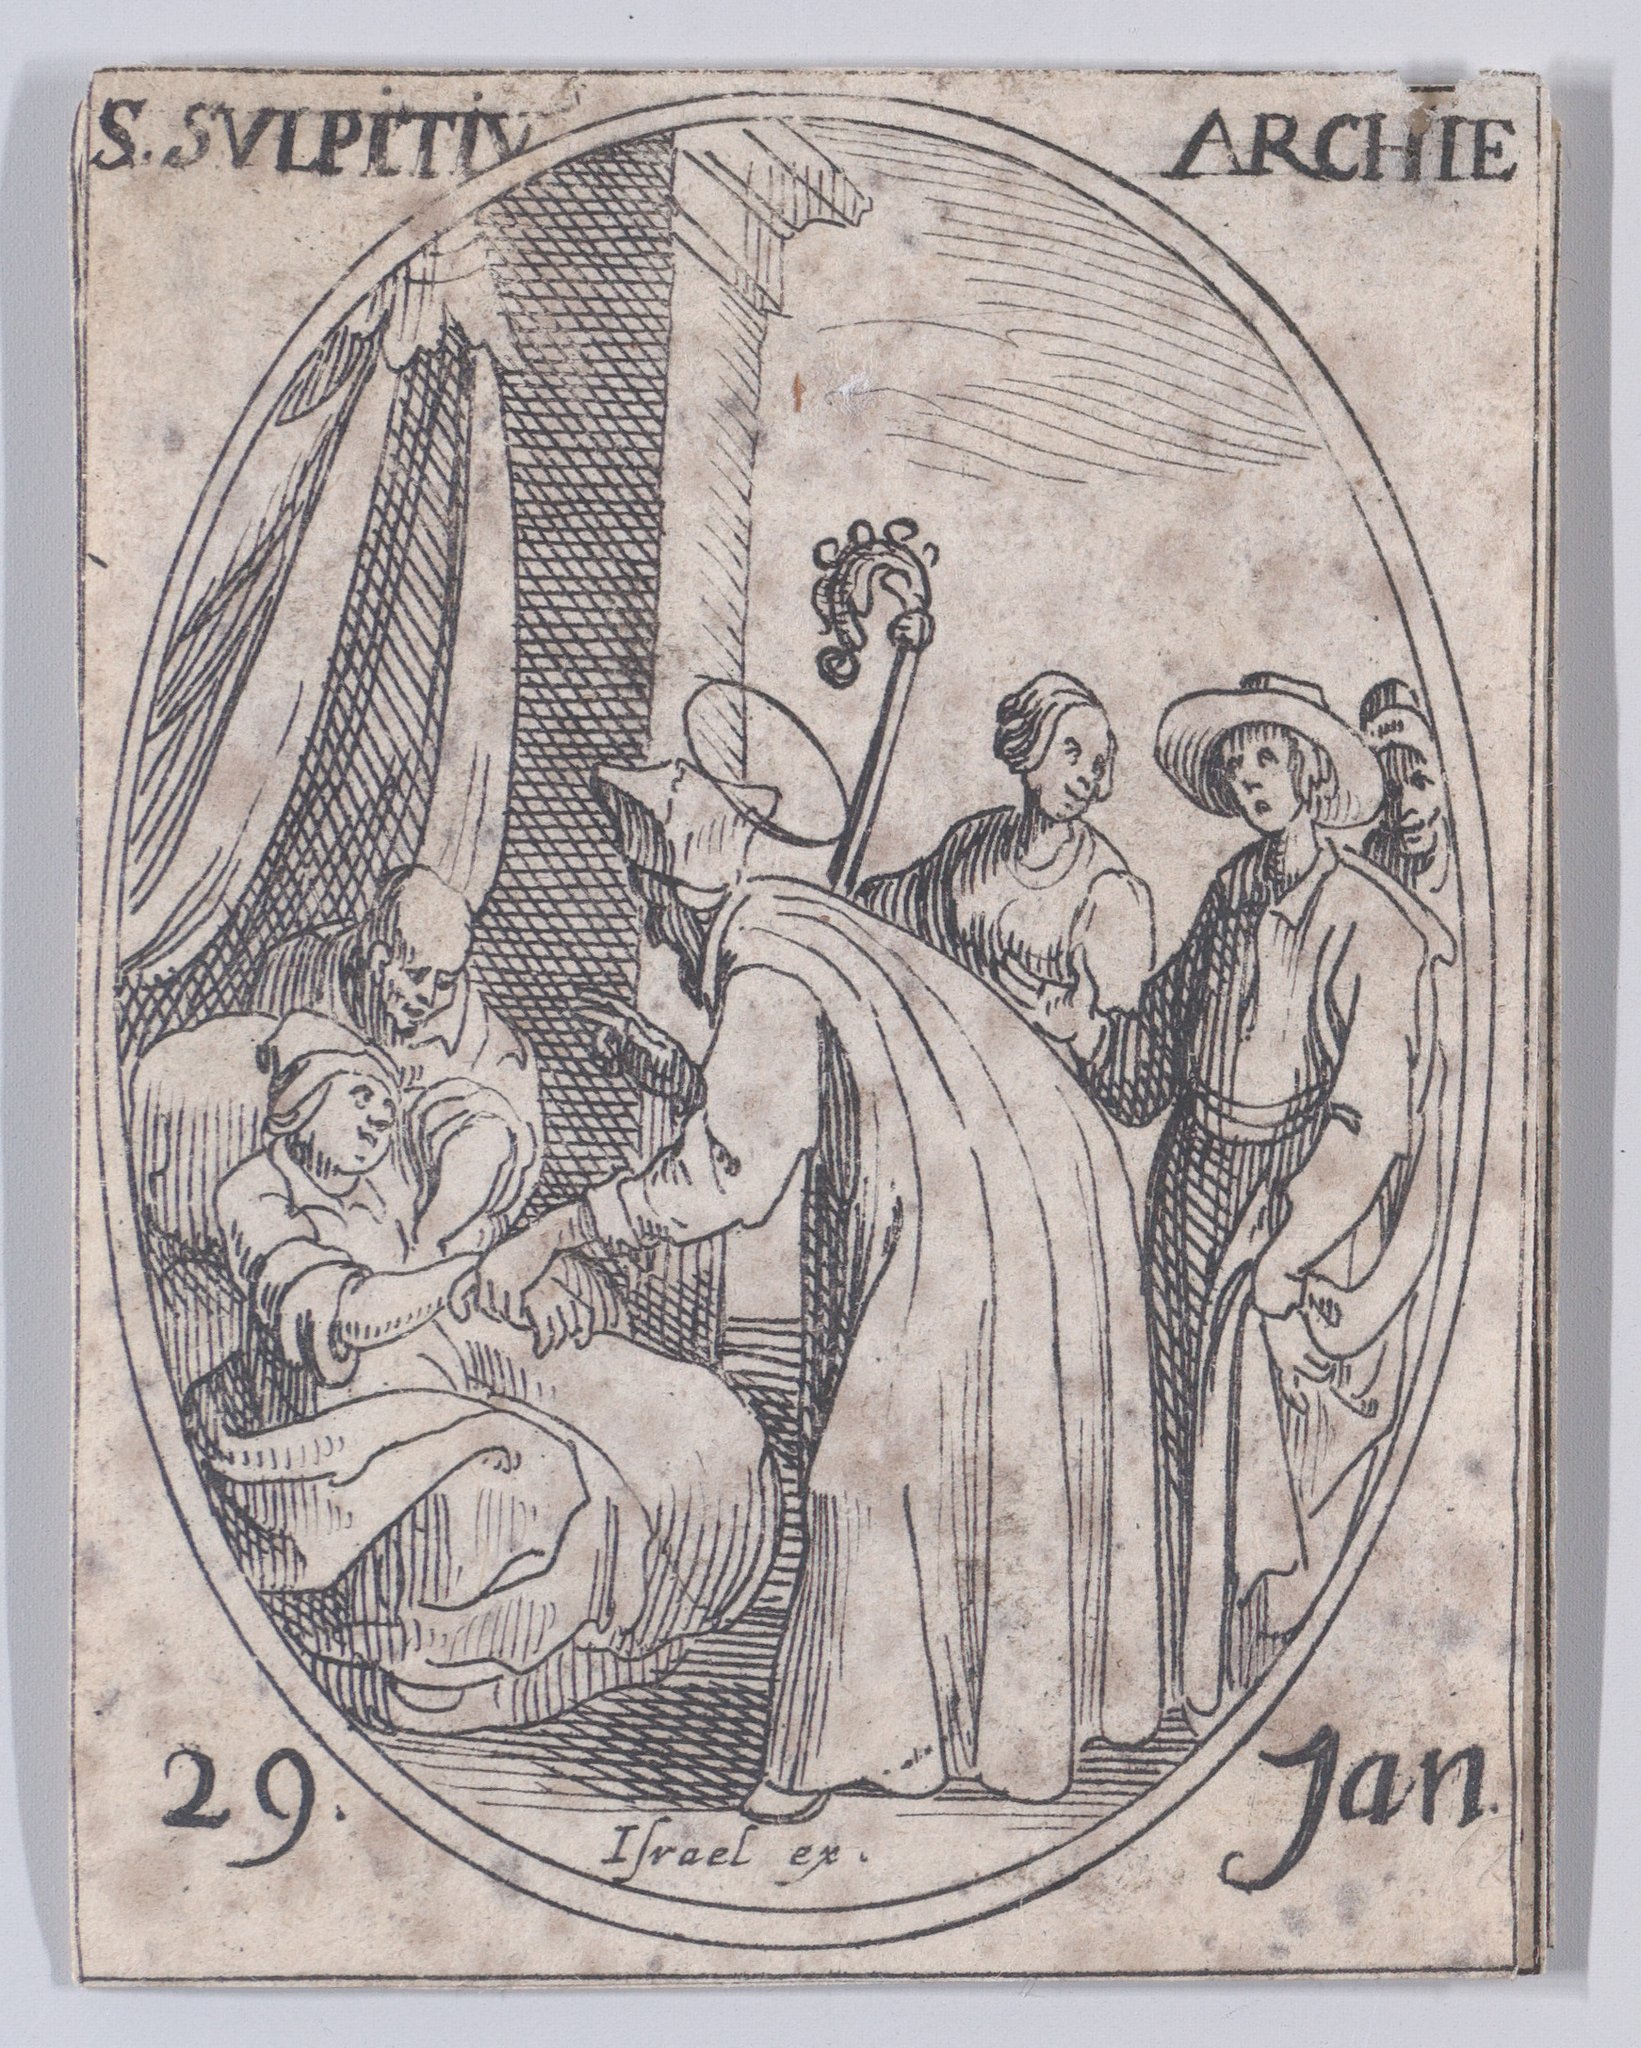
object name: print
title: S. Sulpice, archevêque (St. Sulpitius, Archbishop), January 29th, from "Les Images De Tous Les Saincts et Saintes de L'Année" (Images of All of the Saints and Feast Days of the Year)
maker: jacques callot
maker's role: artist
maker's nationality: french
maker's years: 1592-1635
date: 1636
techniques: etching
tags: men,saints